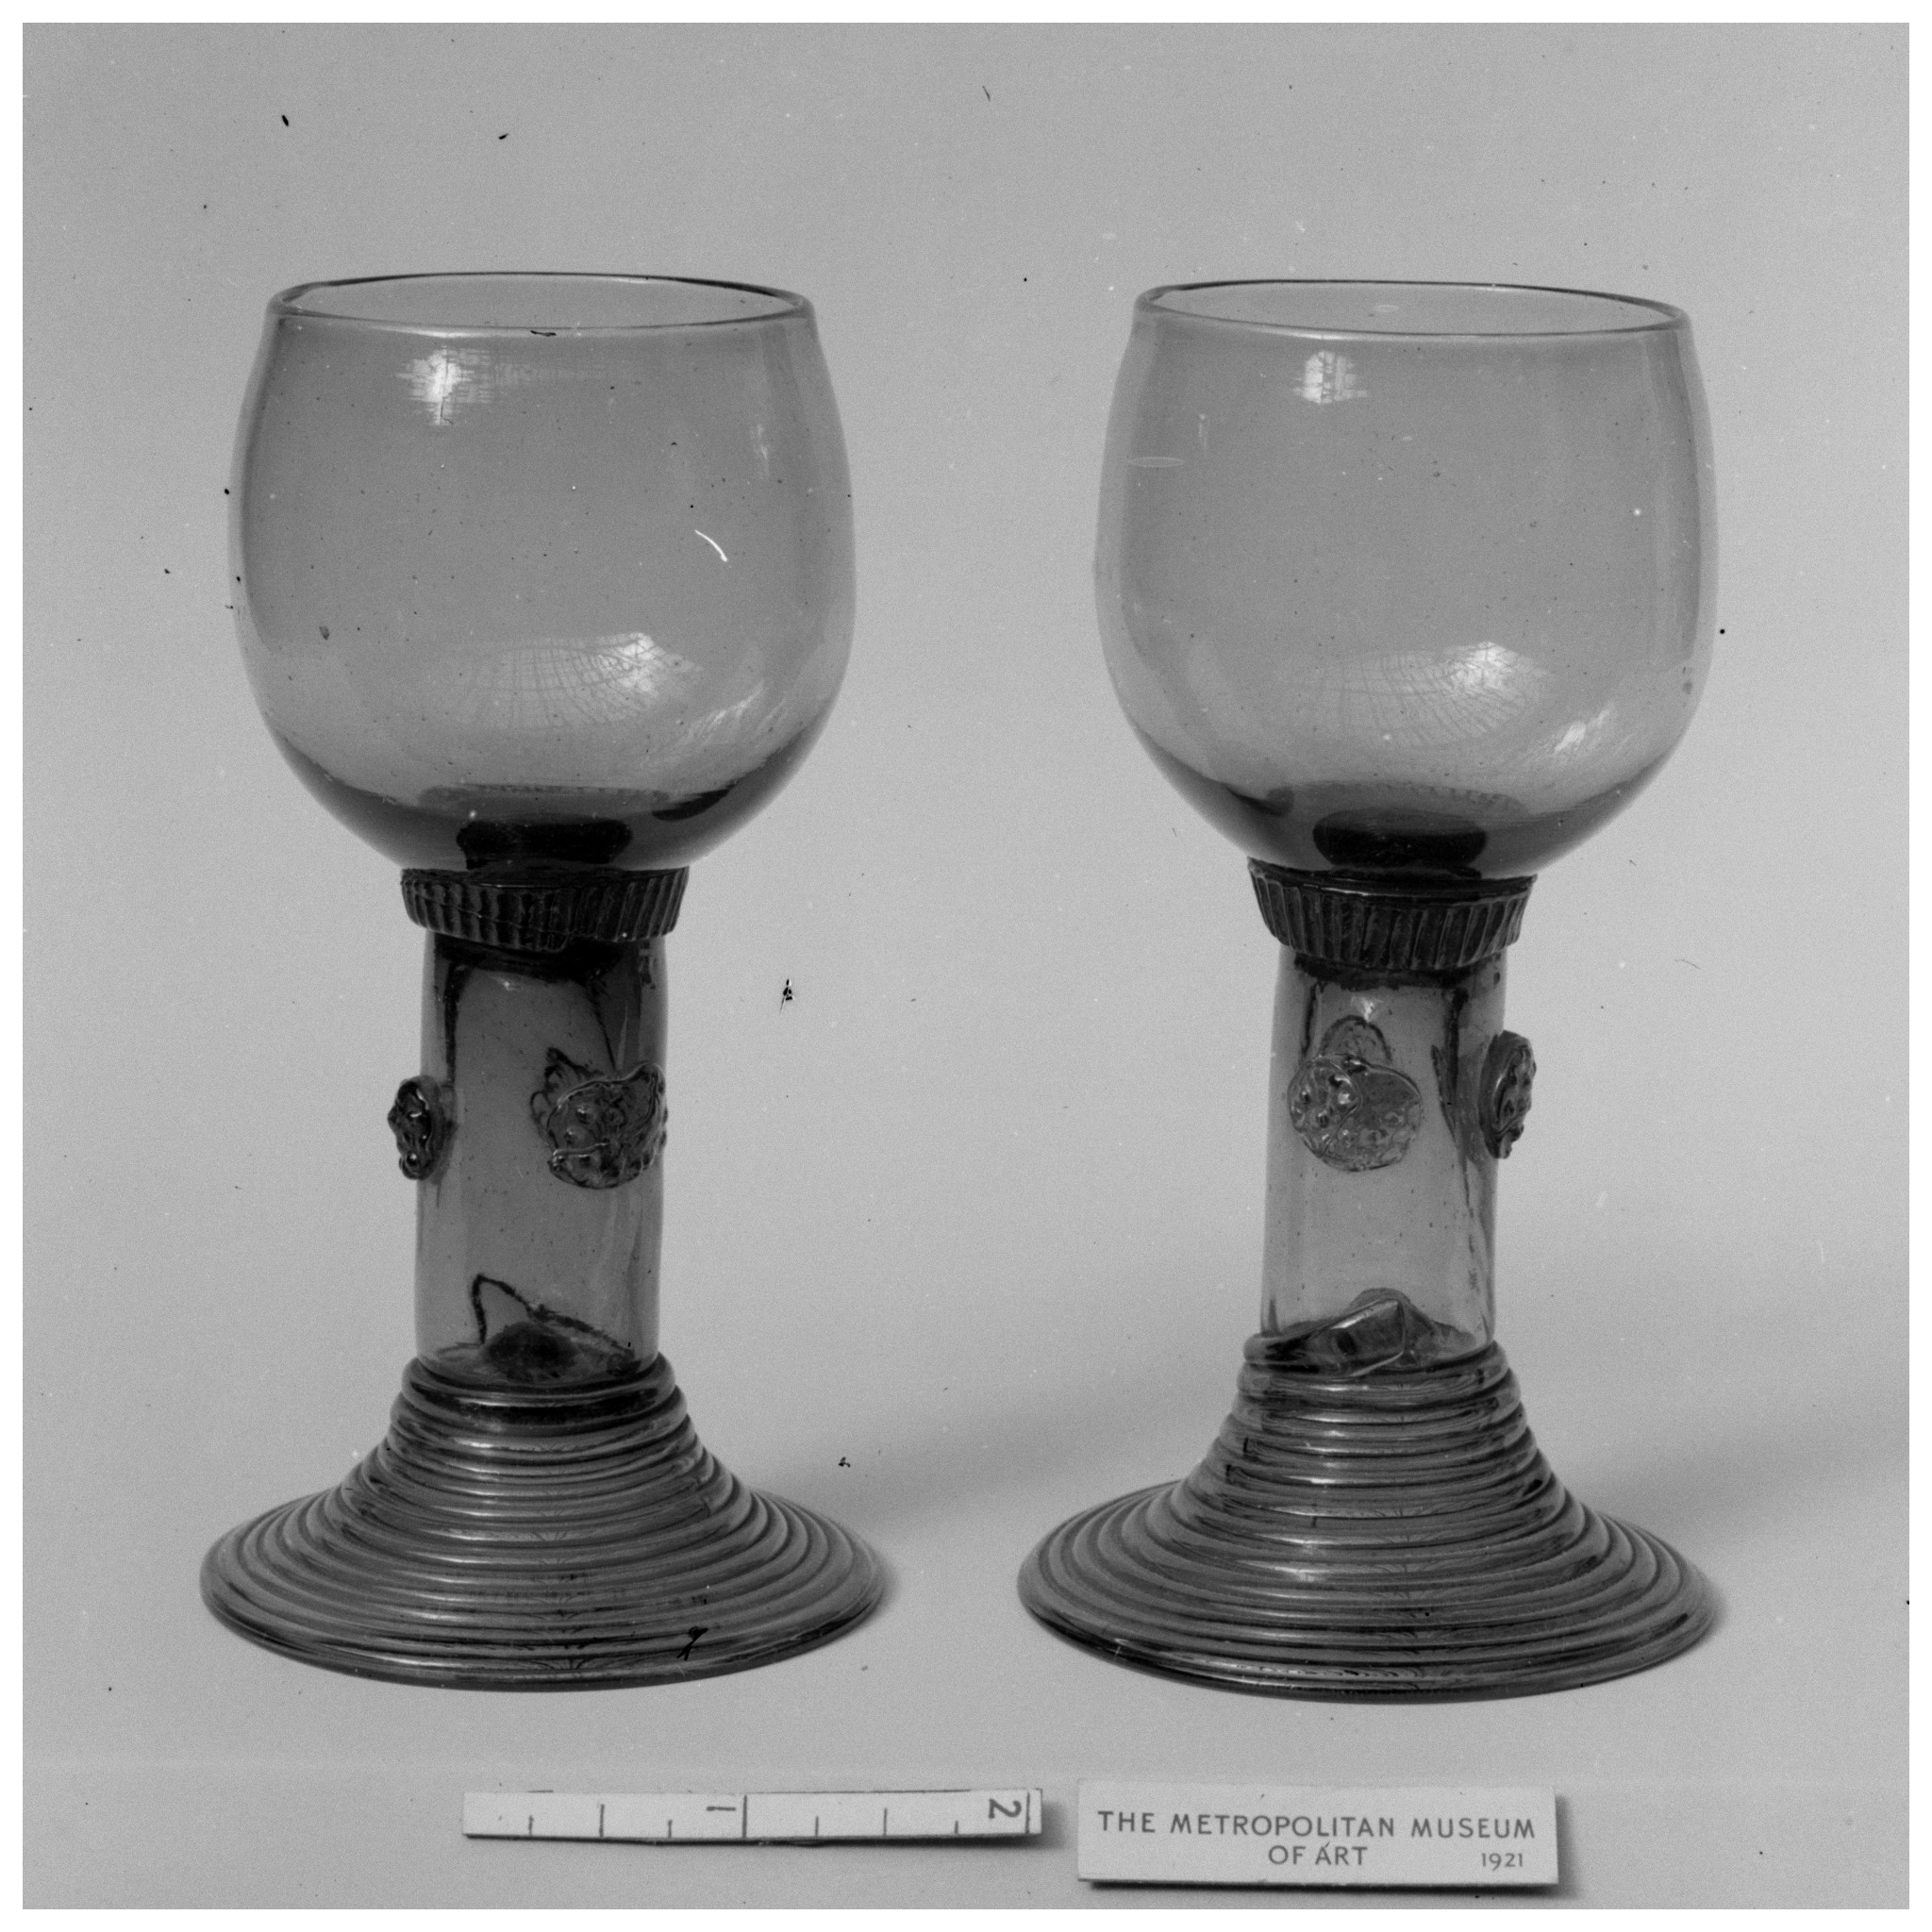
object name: goblet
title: Goblet (Roemer)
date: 1701-1900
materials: glass